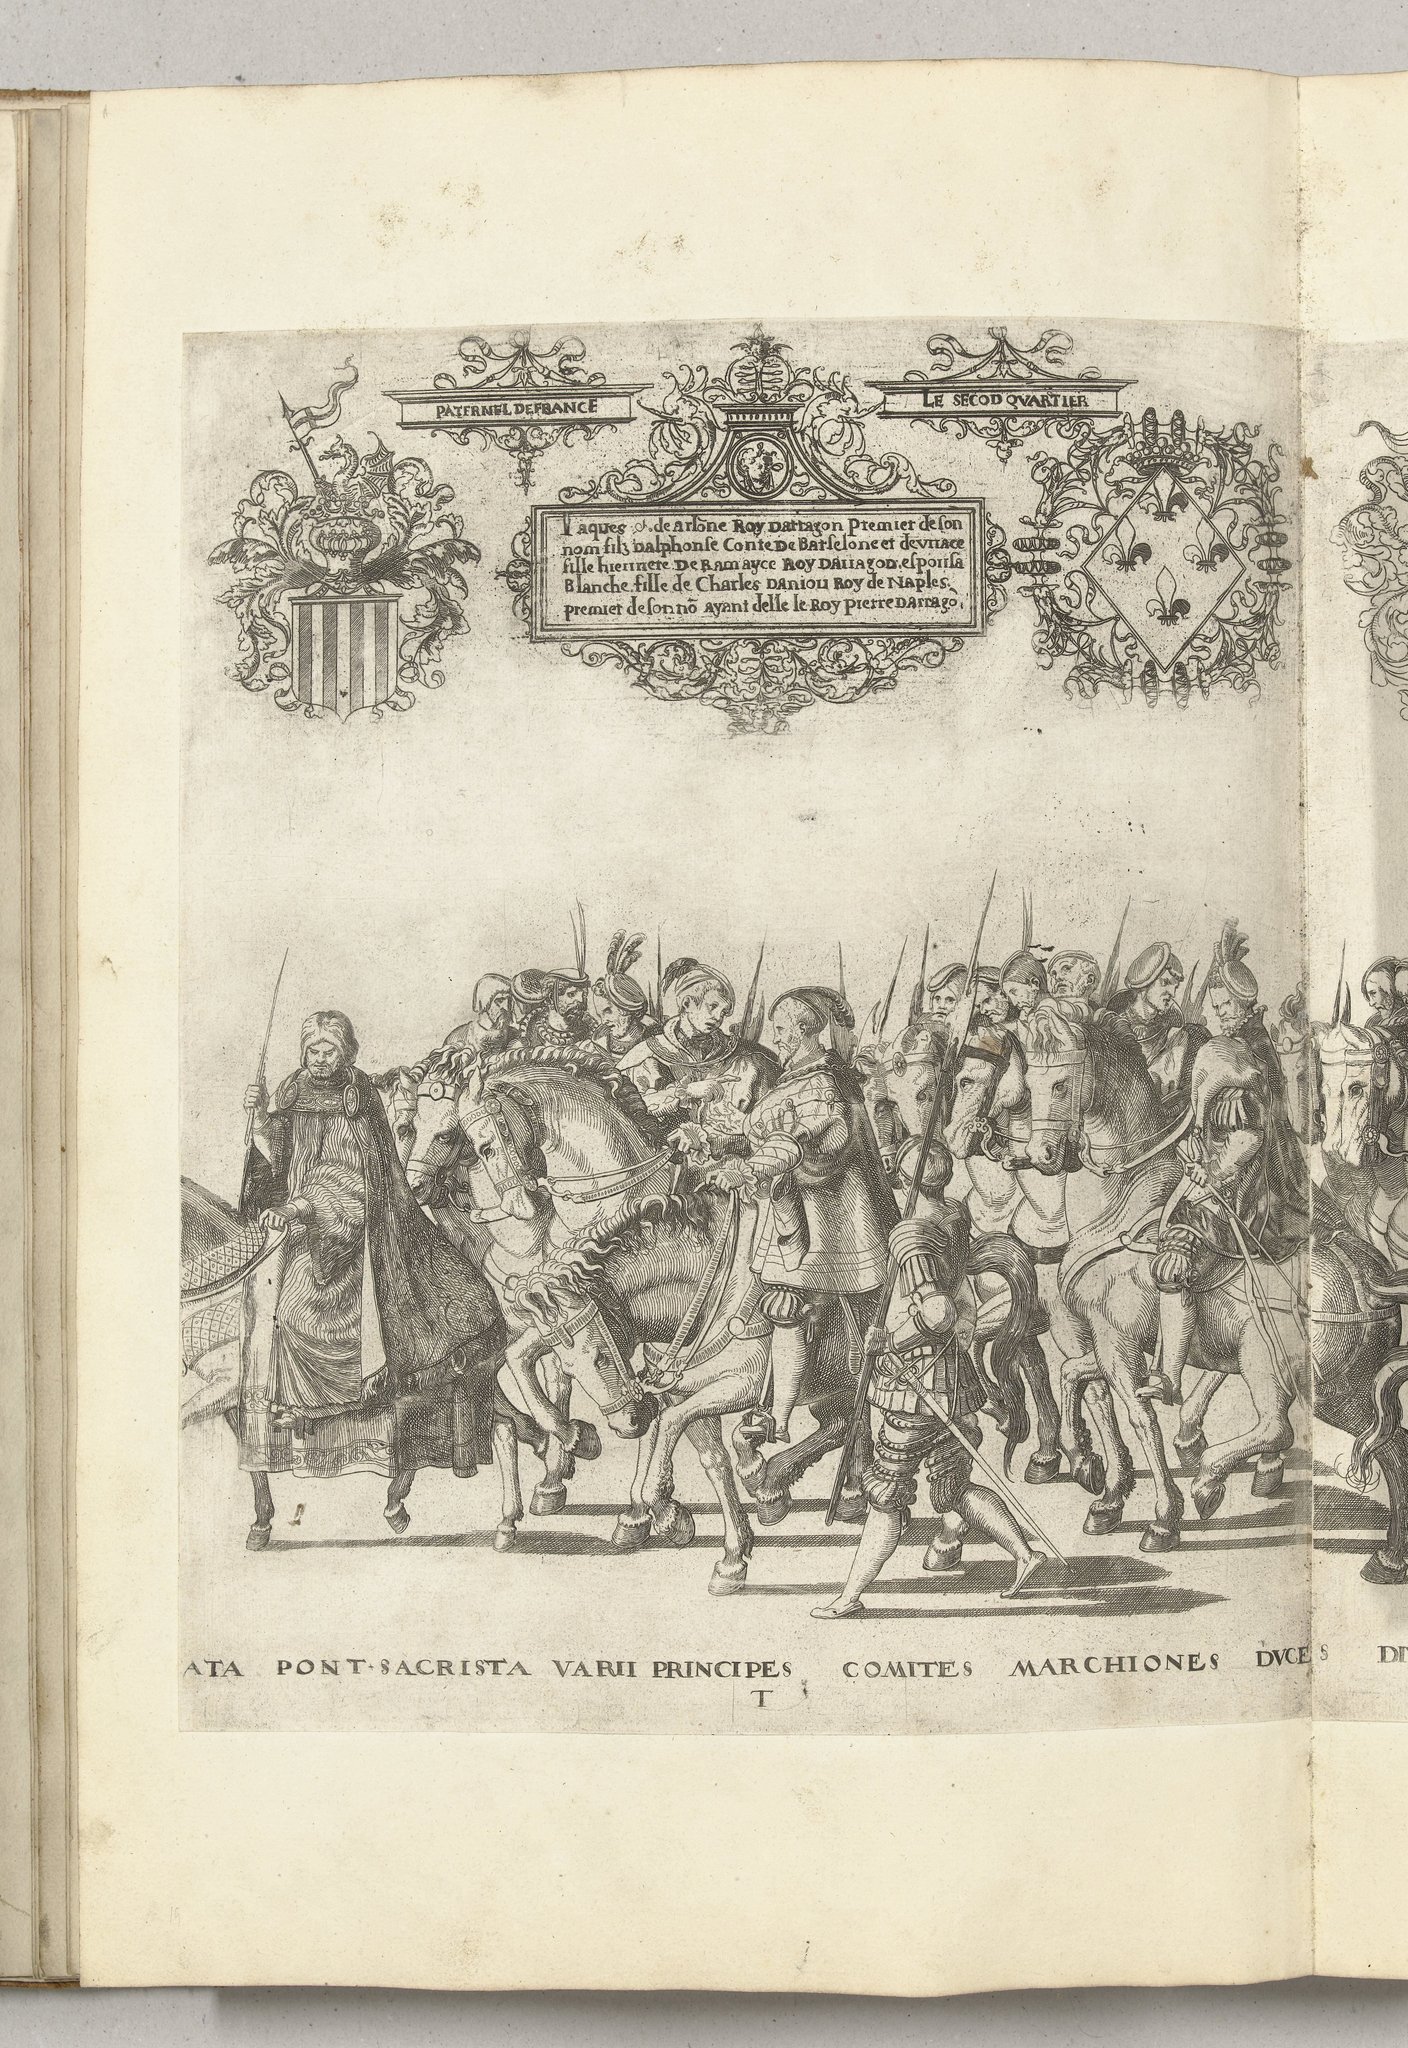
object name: propagandaprent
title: Diverse edelen, plaat T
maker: nicolaas hogenberg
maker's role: draughtsman, painter, print maker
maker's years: 1500-1539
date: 1530-1536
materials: paper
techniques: etching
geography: mechelen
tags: ghent, charles v (holy roman emperor and king of spain), festivities (+ parade, pageant, cavalcade ~ festive activities)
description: Prent in het album waarin zijn ingeplakt de 40 platen die achterelkaar samen het fries vormen van de optocht van Karel V met de paus Clemens VII te Bologna na zijn kroning tot keizer, 24 februari 1530.